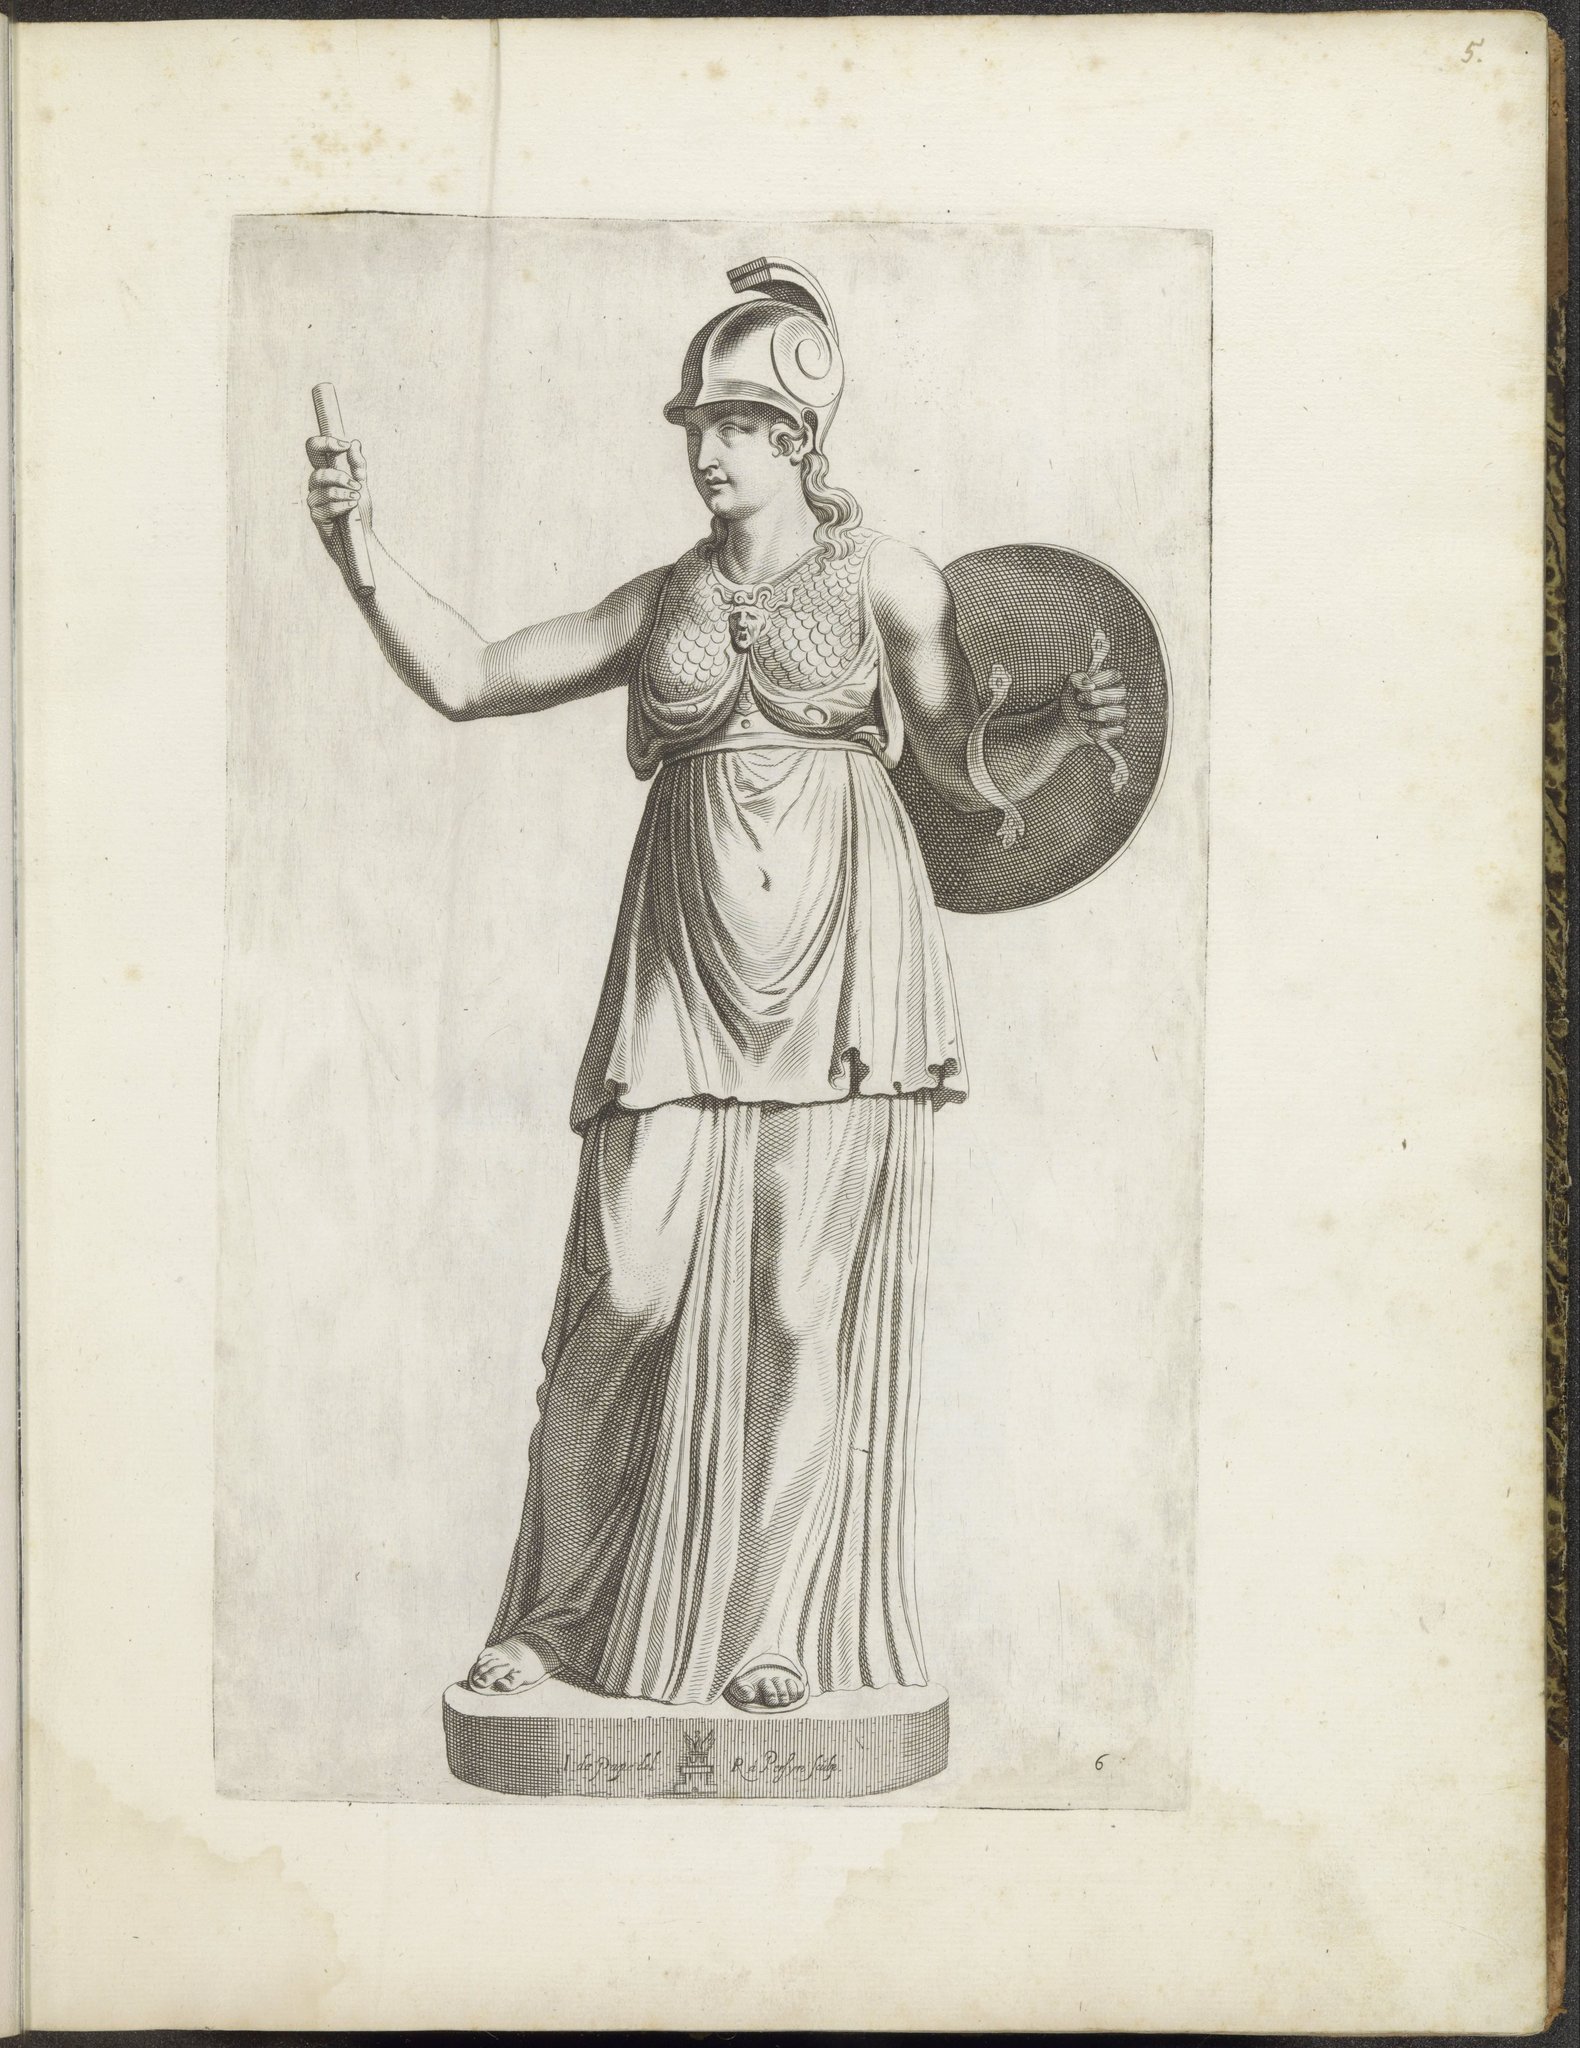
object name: album leaf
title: Standbeeld van staande Minerva met helm en schild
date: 1636-1647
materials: paper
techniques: engraving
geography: rome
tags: (story of) minerva (pallas, athena), piece of sculpture, reproduction of a piece of sculpture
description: Standbeeld van staande Minerva met helm en schild. Midden onder op de basis het wapenschild van Vincenzo Giustiniani. Prent maakt deel uit van een album met een serie prenten naar de sculpturen in de verzameling in de Galleria Giustiniani te Rome.